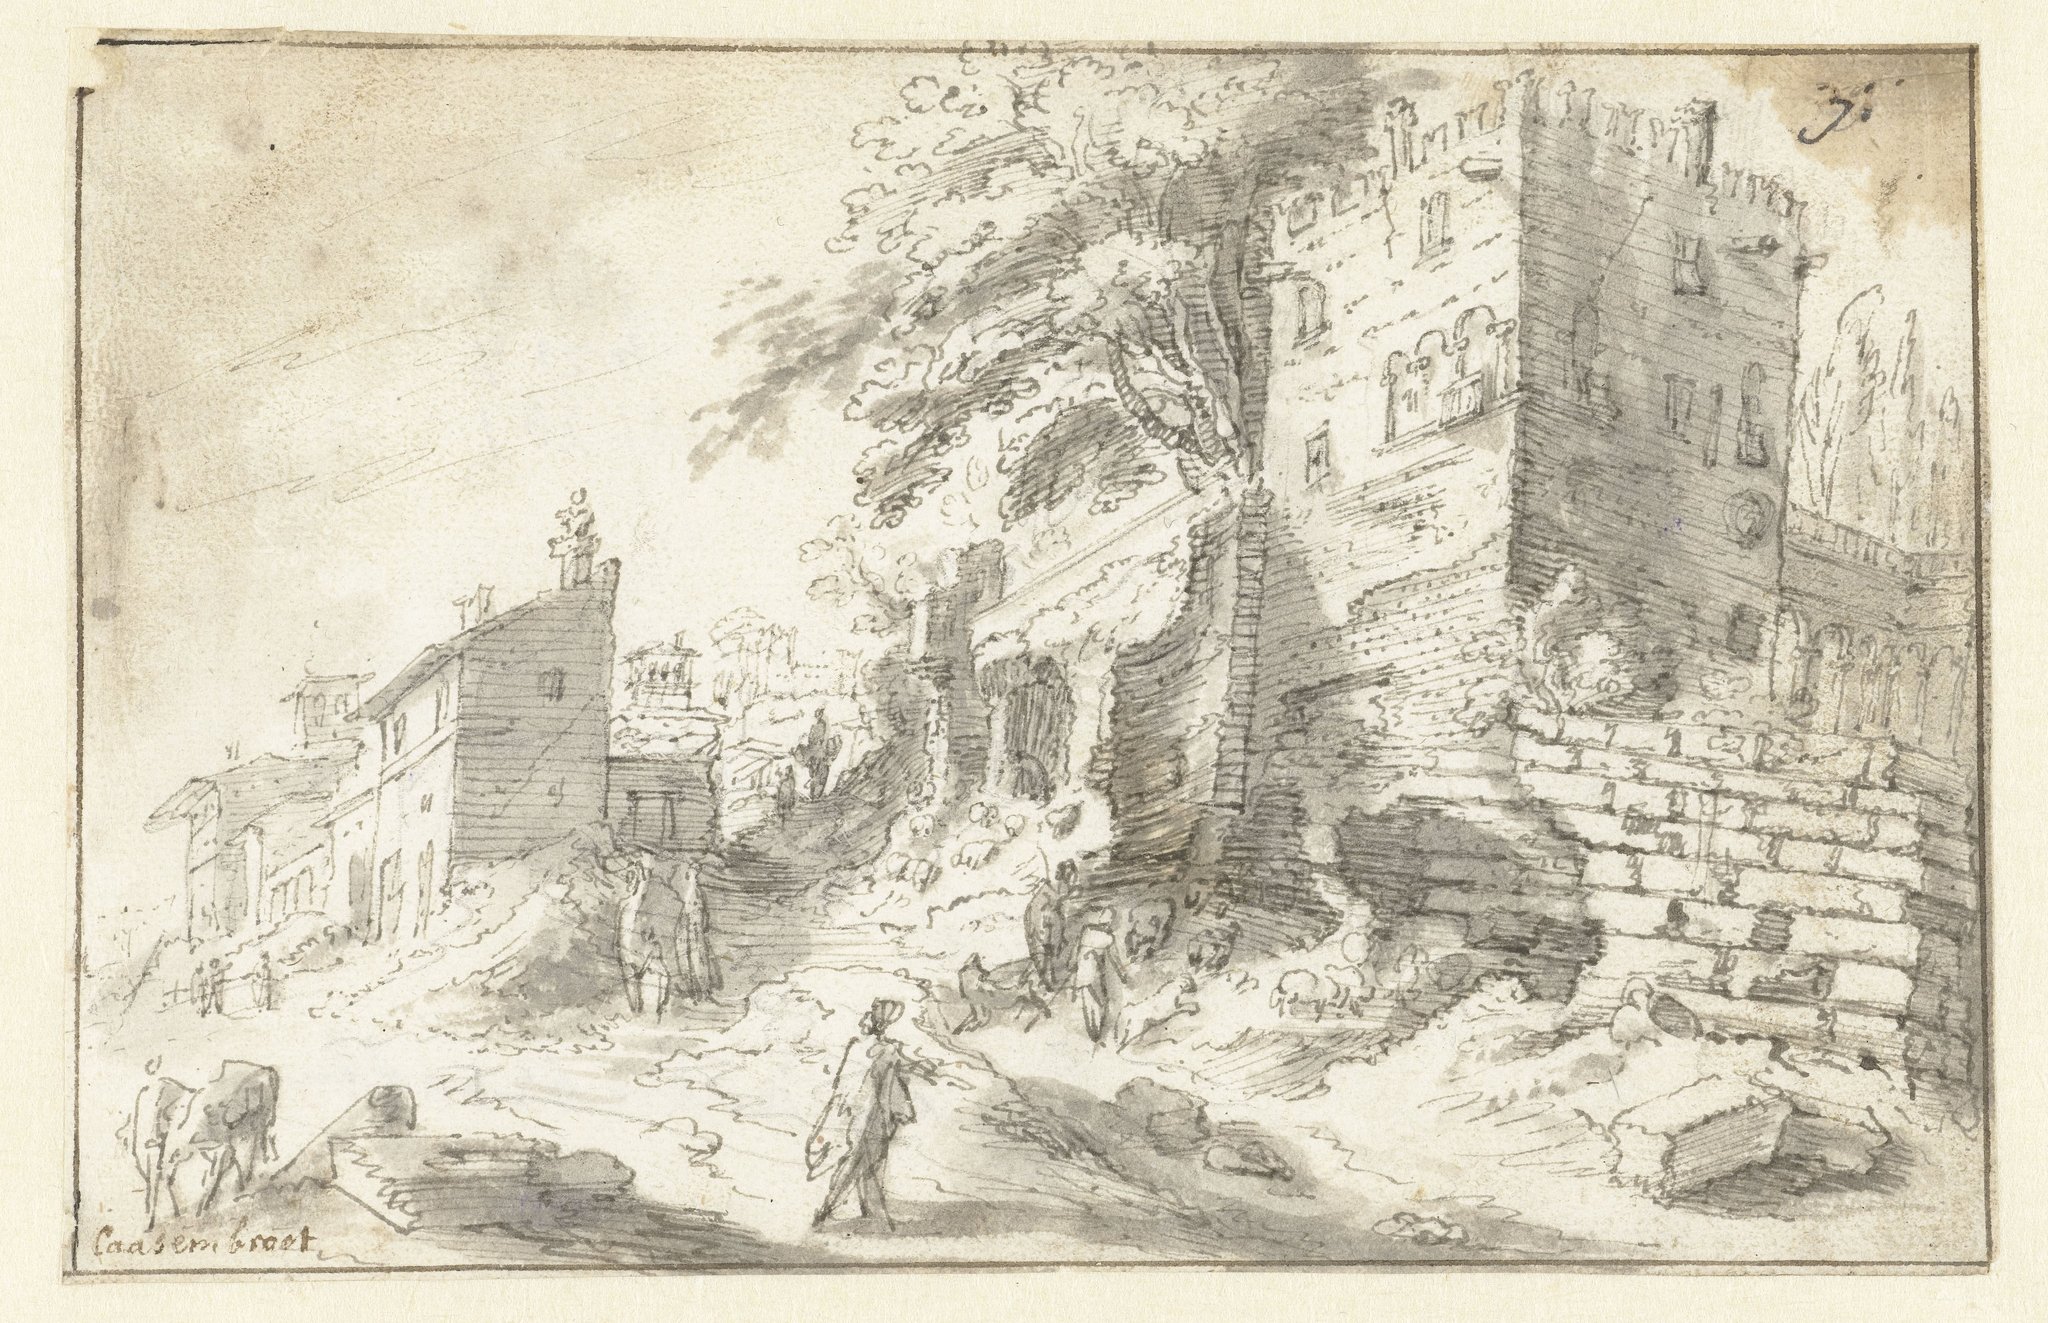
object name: drawing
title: Italiaans landschap met ruïnes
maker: abraham de casembroot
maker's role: draughtsman, print maker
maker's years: 1573-1658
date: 1650-1675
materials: ink, paper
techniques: brush, pen